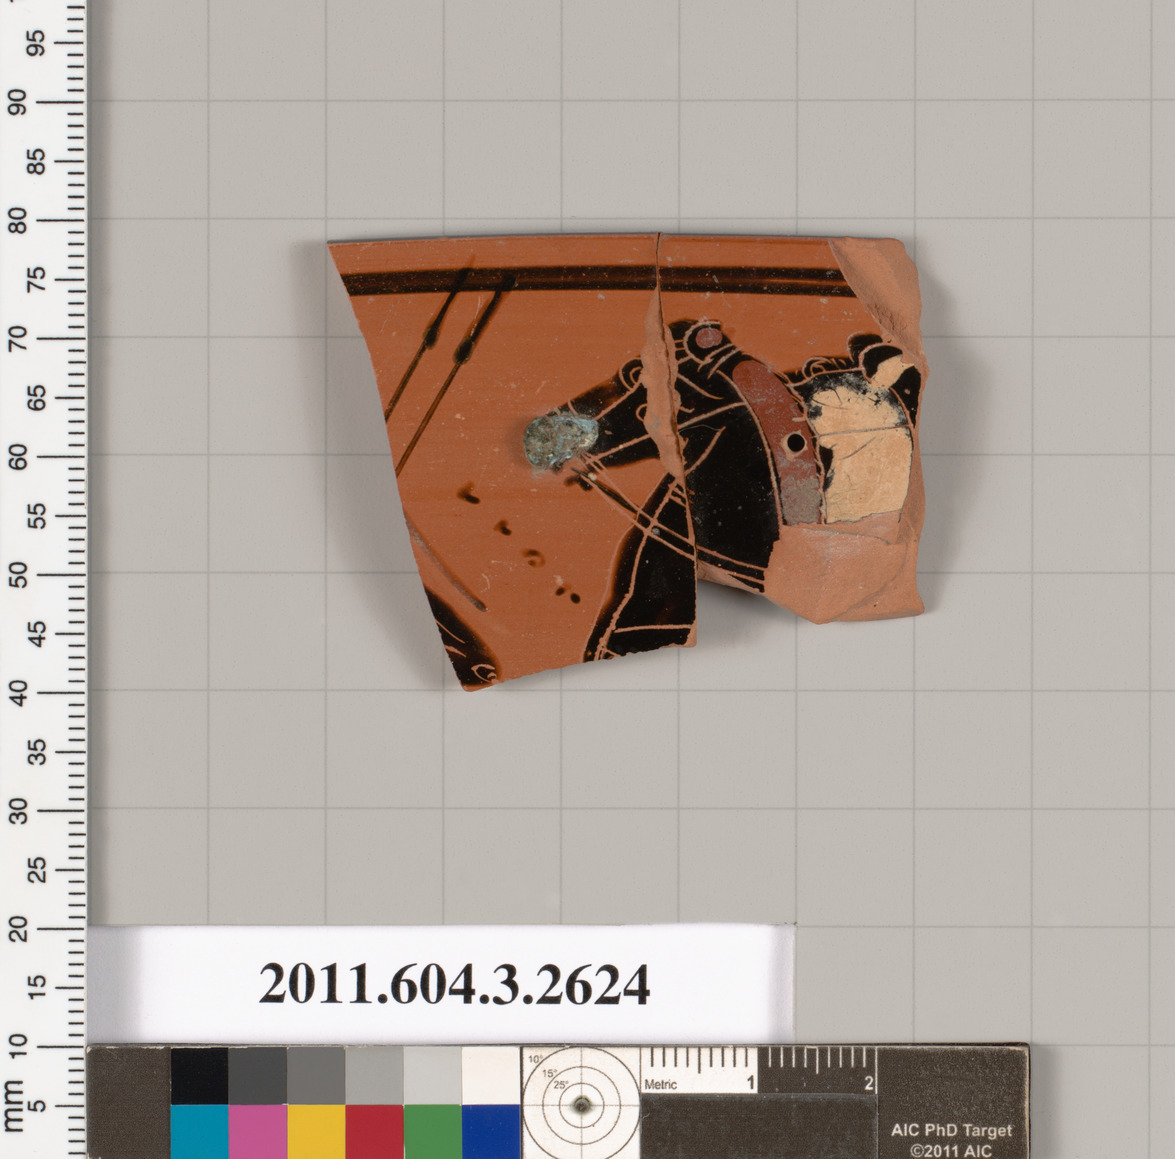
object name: kylix fragment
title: Terracotta rim fragment of a kylix (drinking cup)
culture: greek, attic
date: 550-526 BCE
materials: terracotta